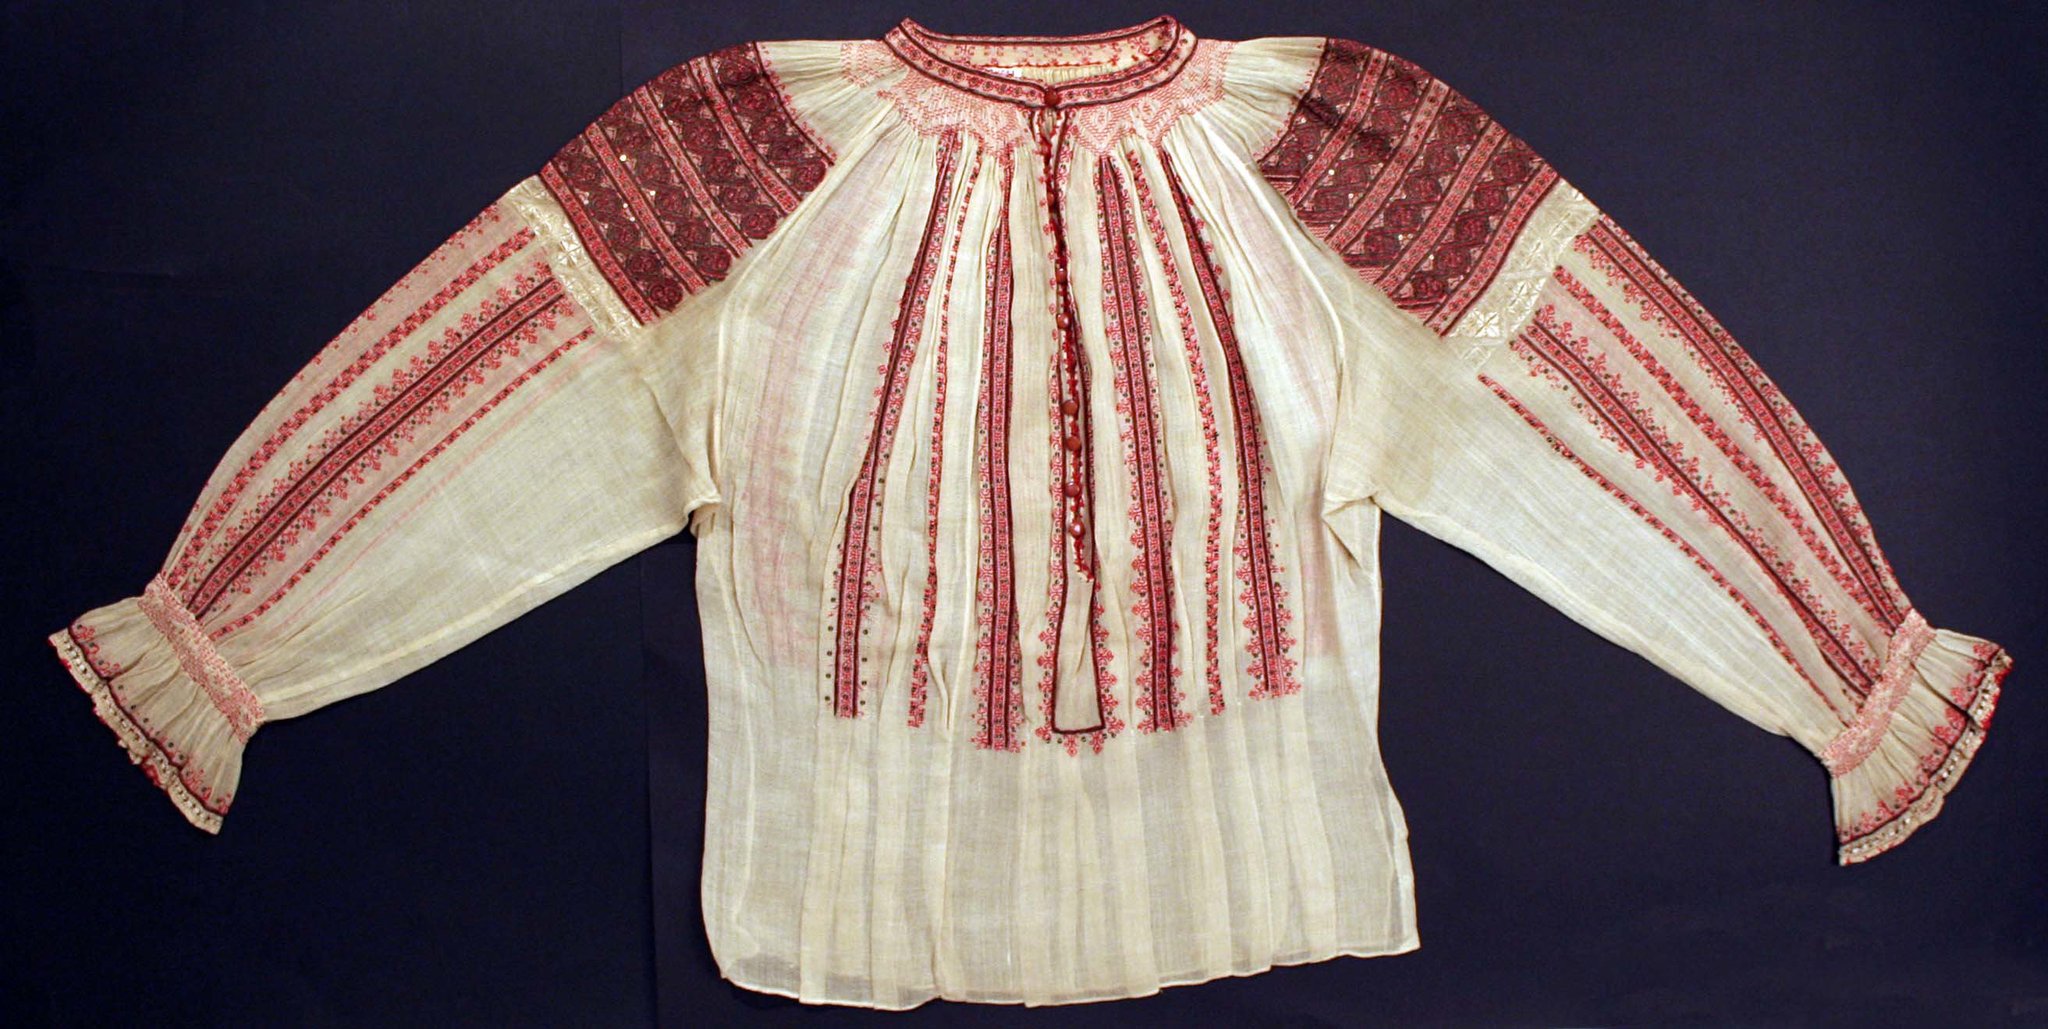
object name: blouse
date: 1801-1900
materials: cotton, metal, silk